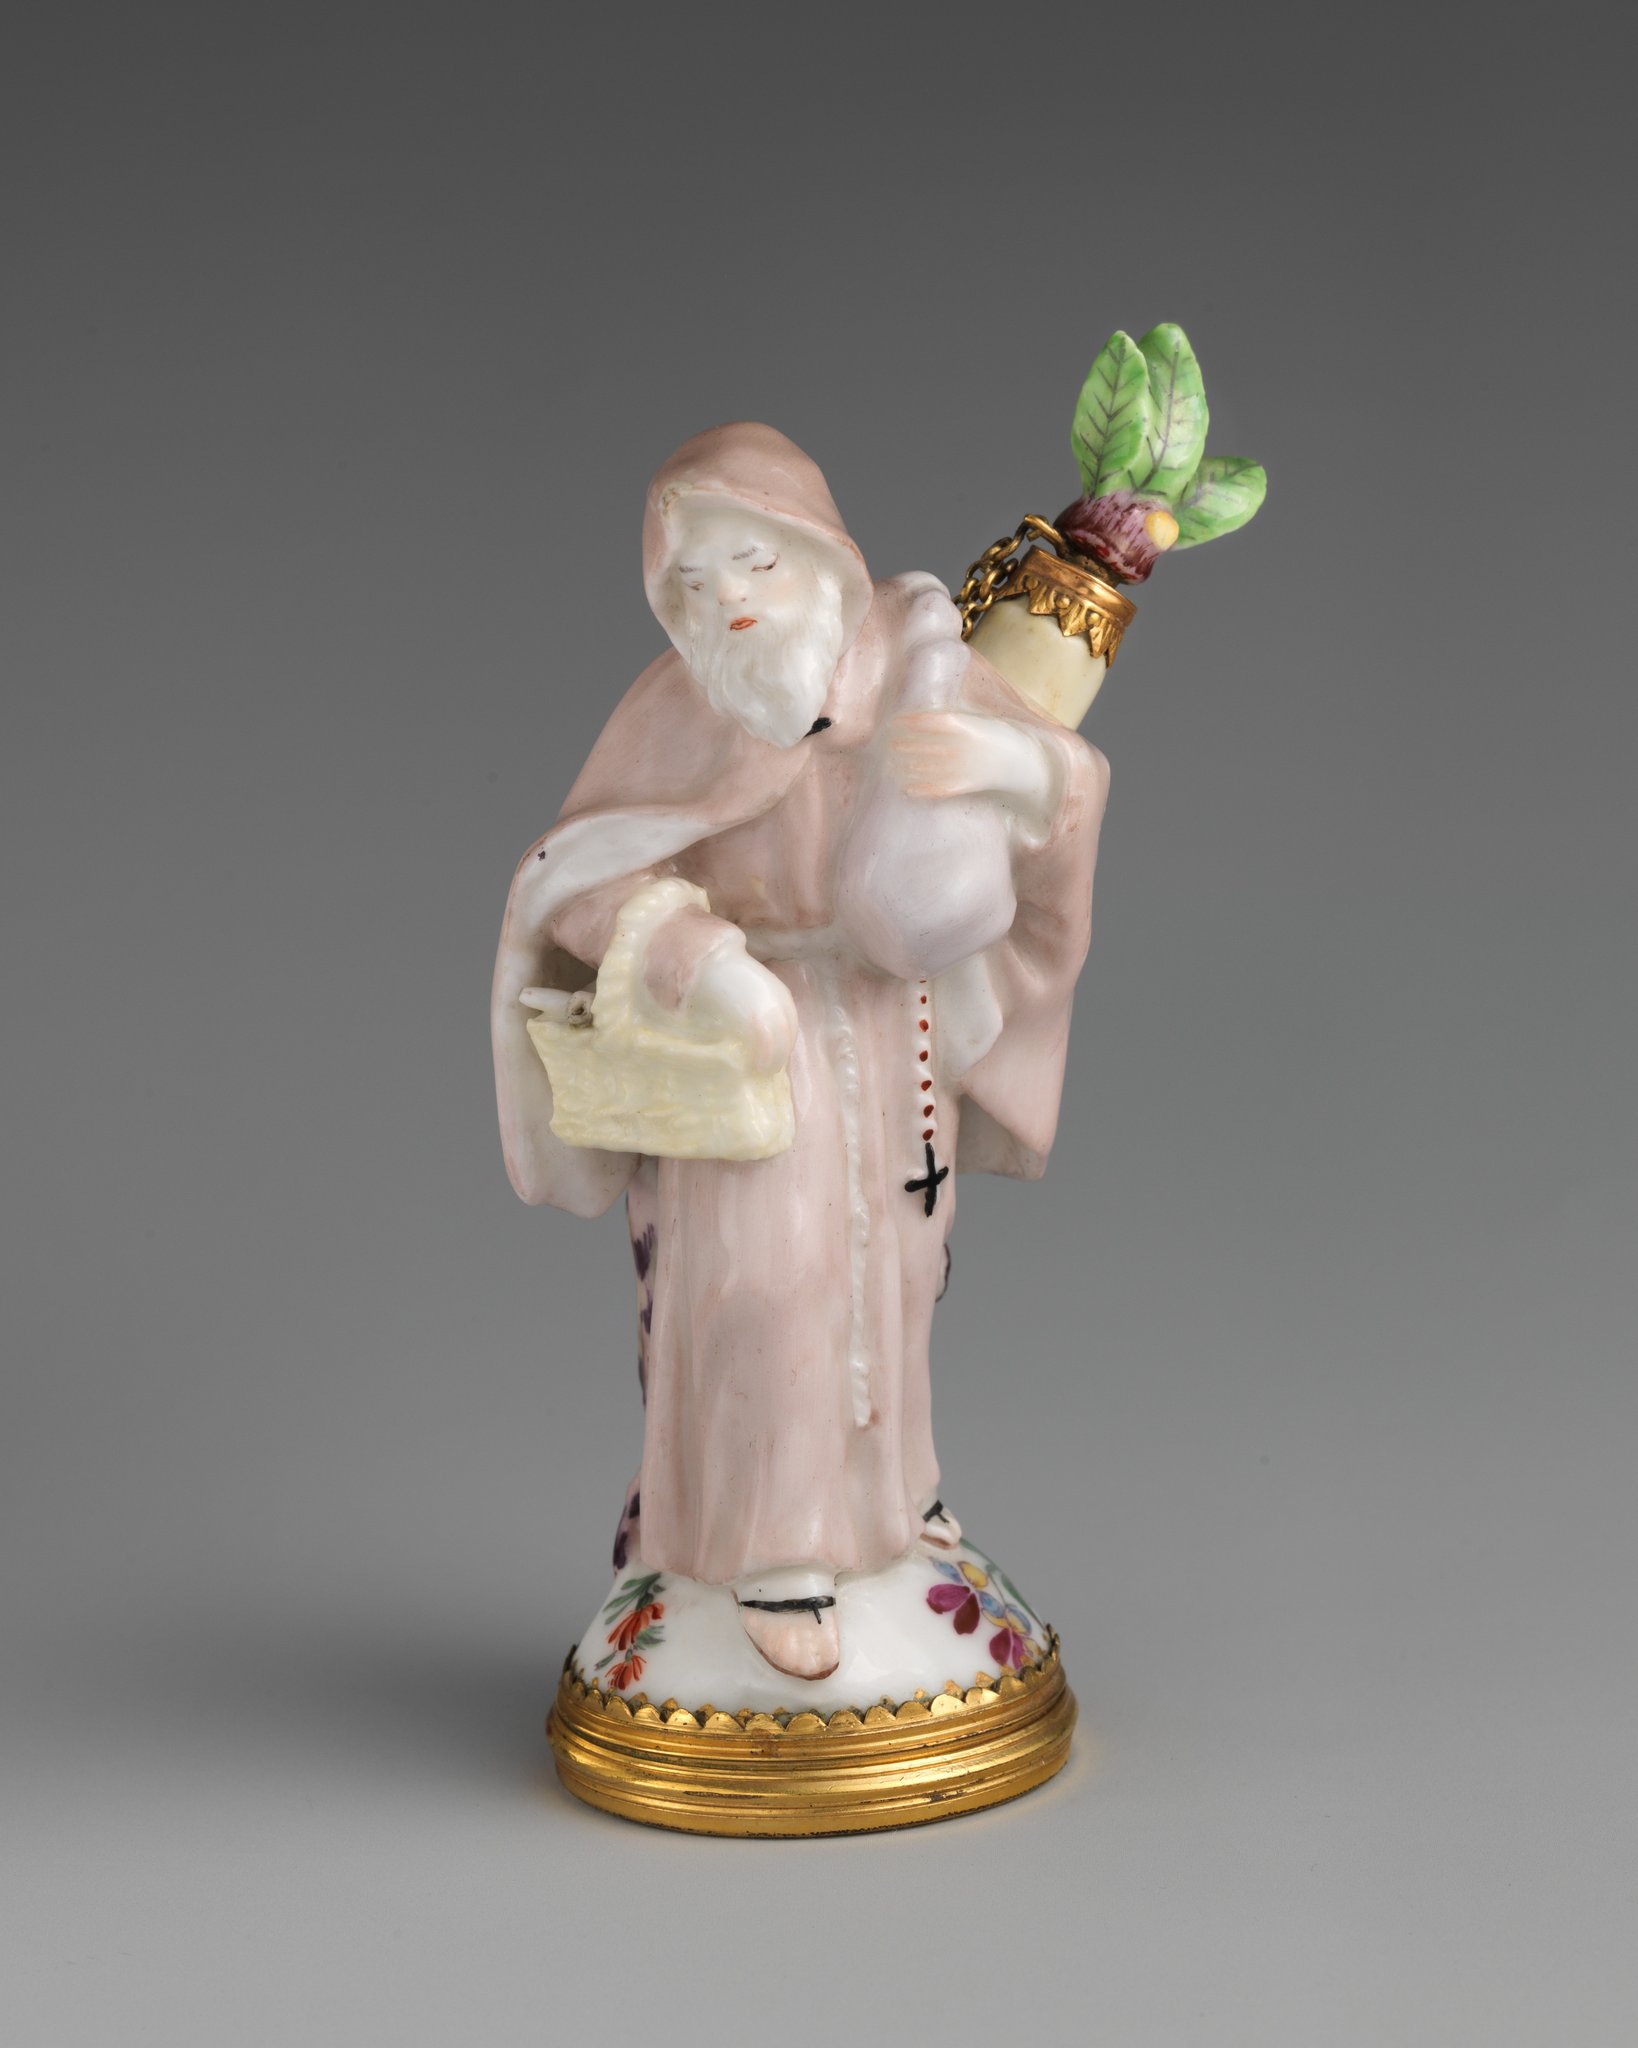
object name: toy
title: Friar with basket and sack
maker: chelsea porcelain manufactory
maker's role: factory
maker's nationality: british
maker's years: 1744-1784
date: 1755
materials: soft paste porcelain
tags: men,cross